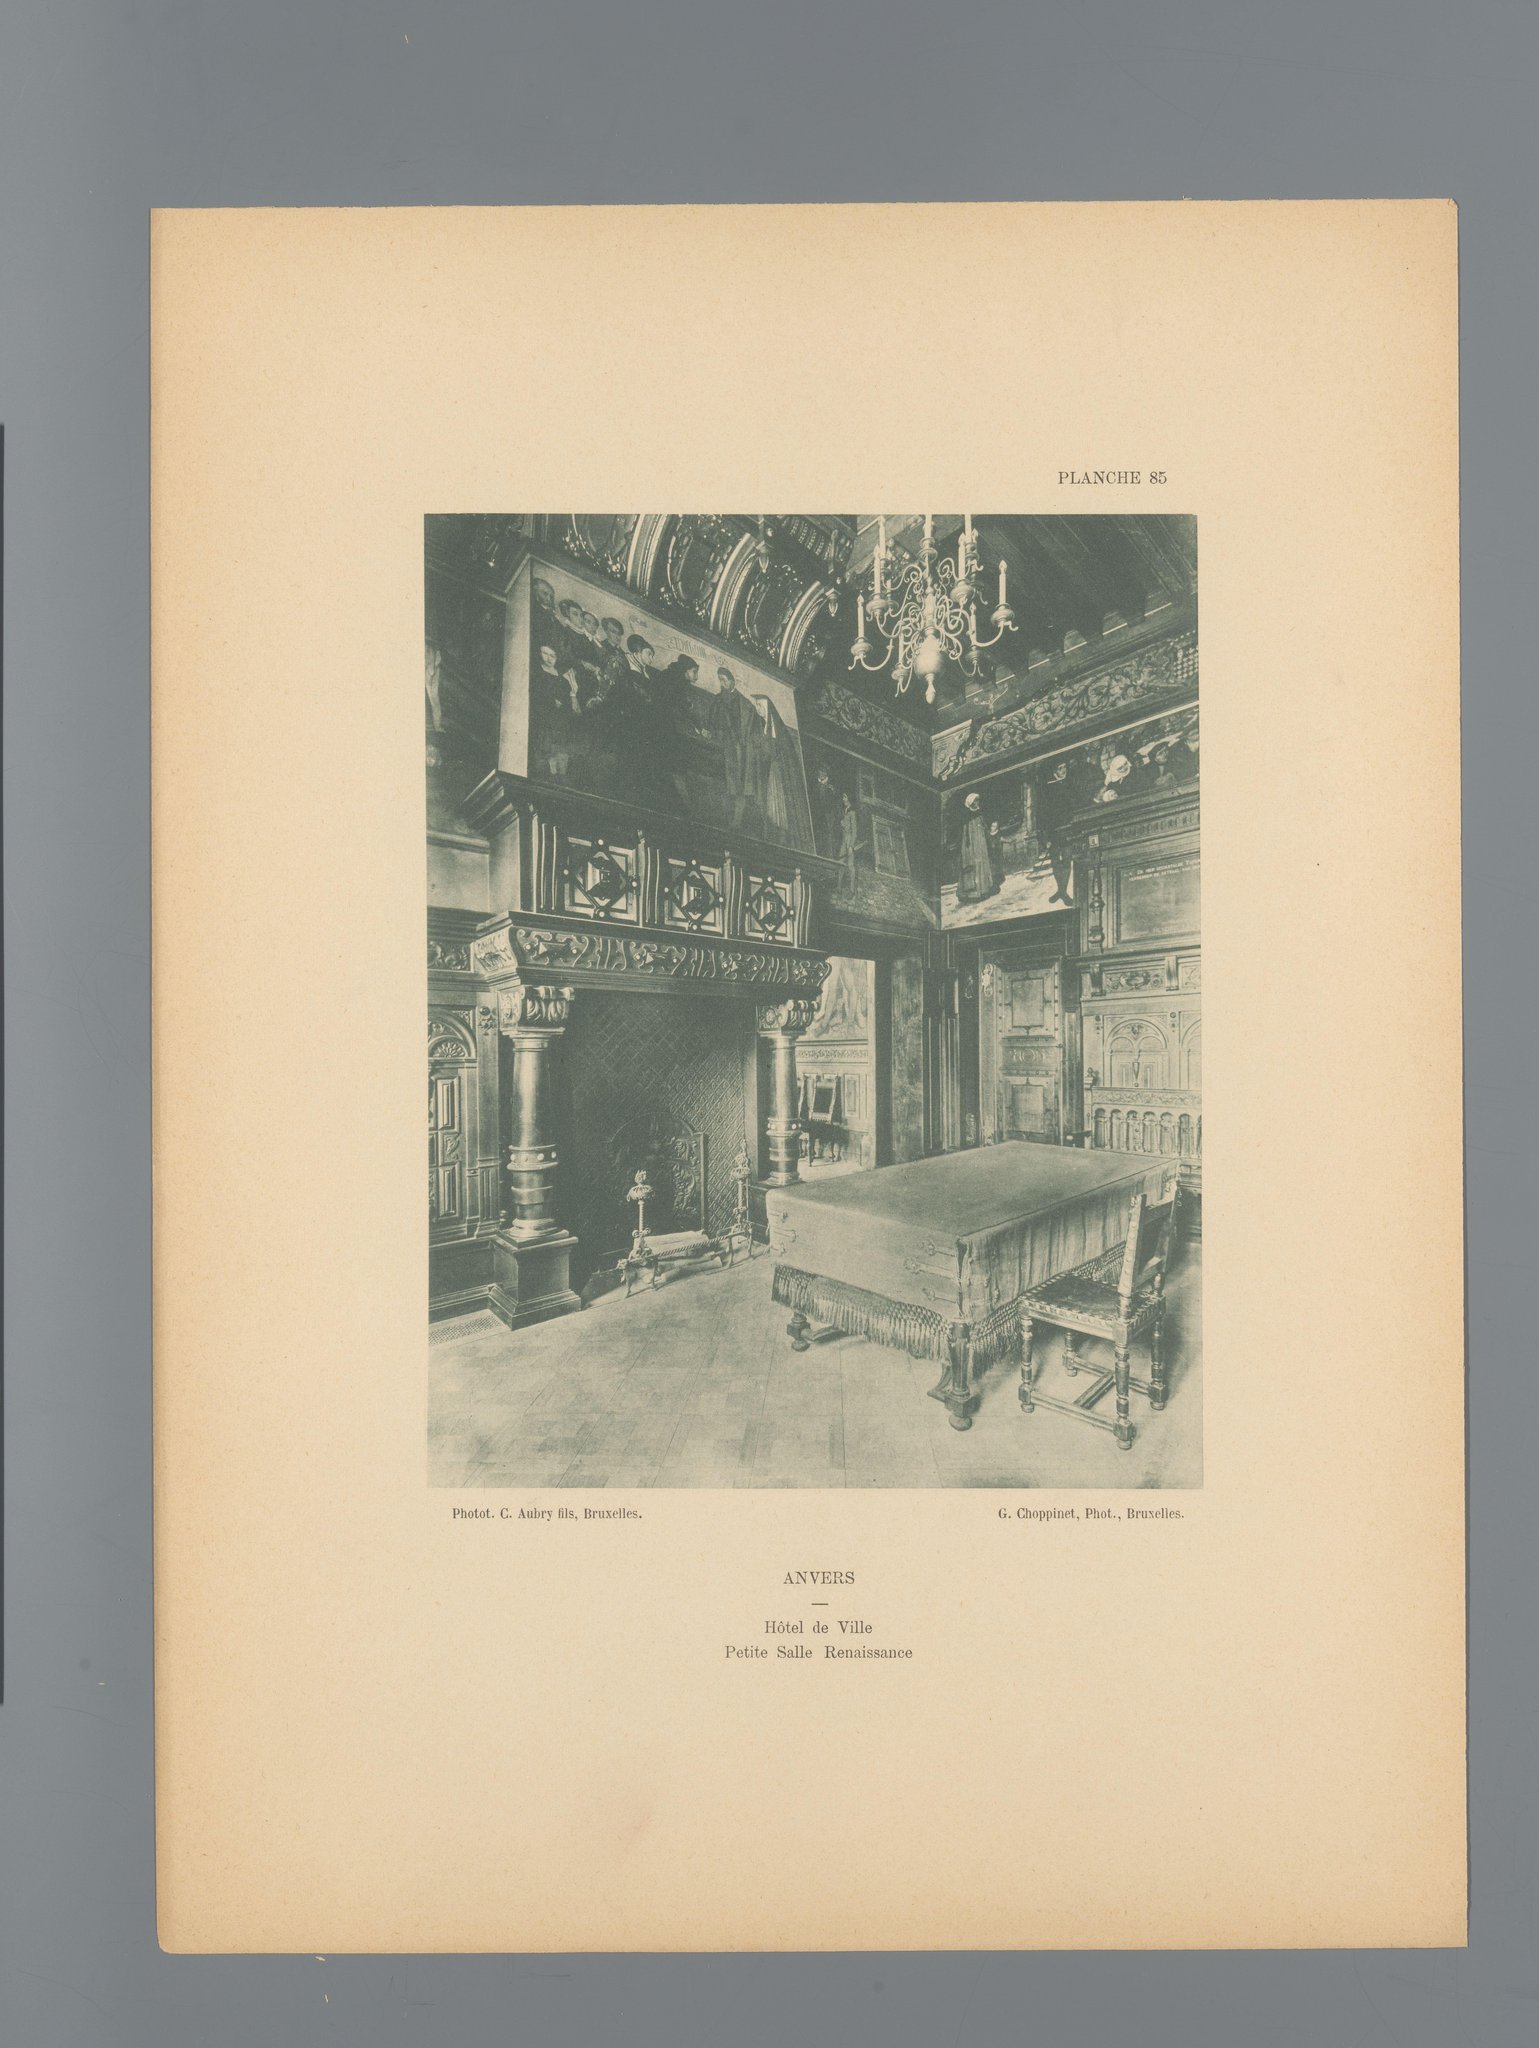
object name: photomechanical print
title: Gezicht op een kleine zaal in renaissancestijl in het stadhuis van Antwerpen, België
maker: gustave choppinet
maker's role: fotograaf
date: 1893-1898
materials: paper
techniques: photograph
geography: brussels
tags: townhall, interior of the house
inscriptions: inscription: ‘Hôtel de Ville/ Petite Salle Renaissance’, number: ‘PLANCHE 85’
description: Deze prent maakt deel uit van een omslag met 89 prenten en 5 tekstbladen.